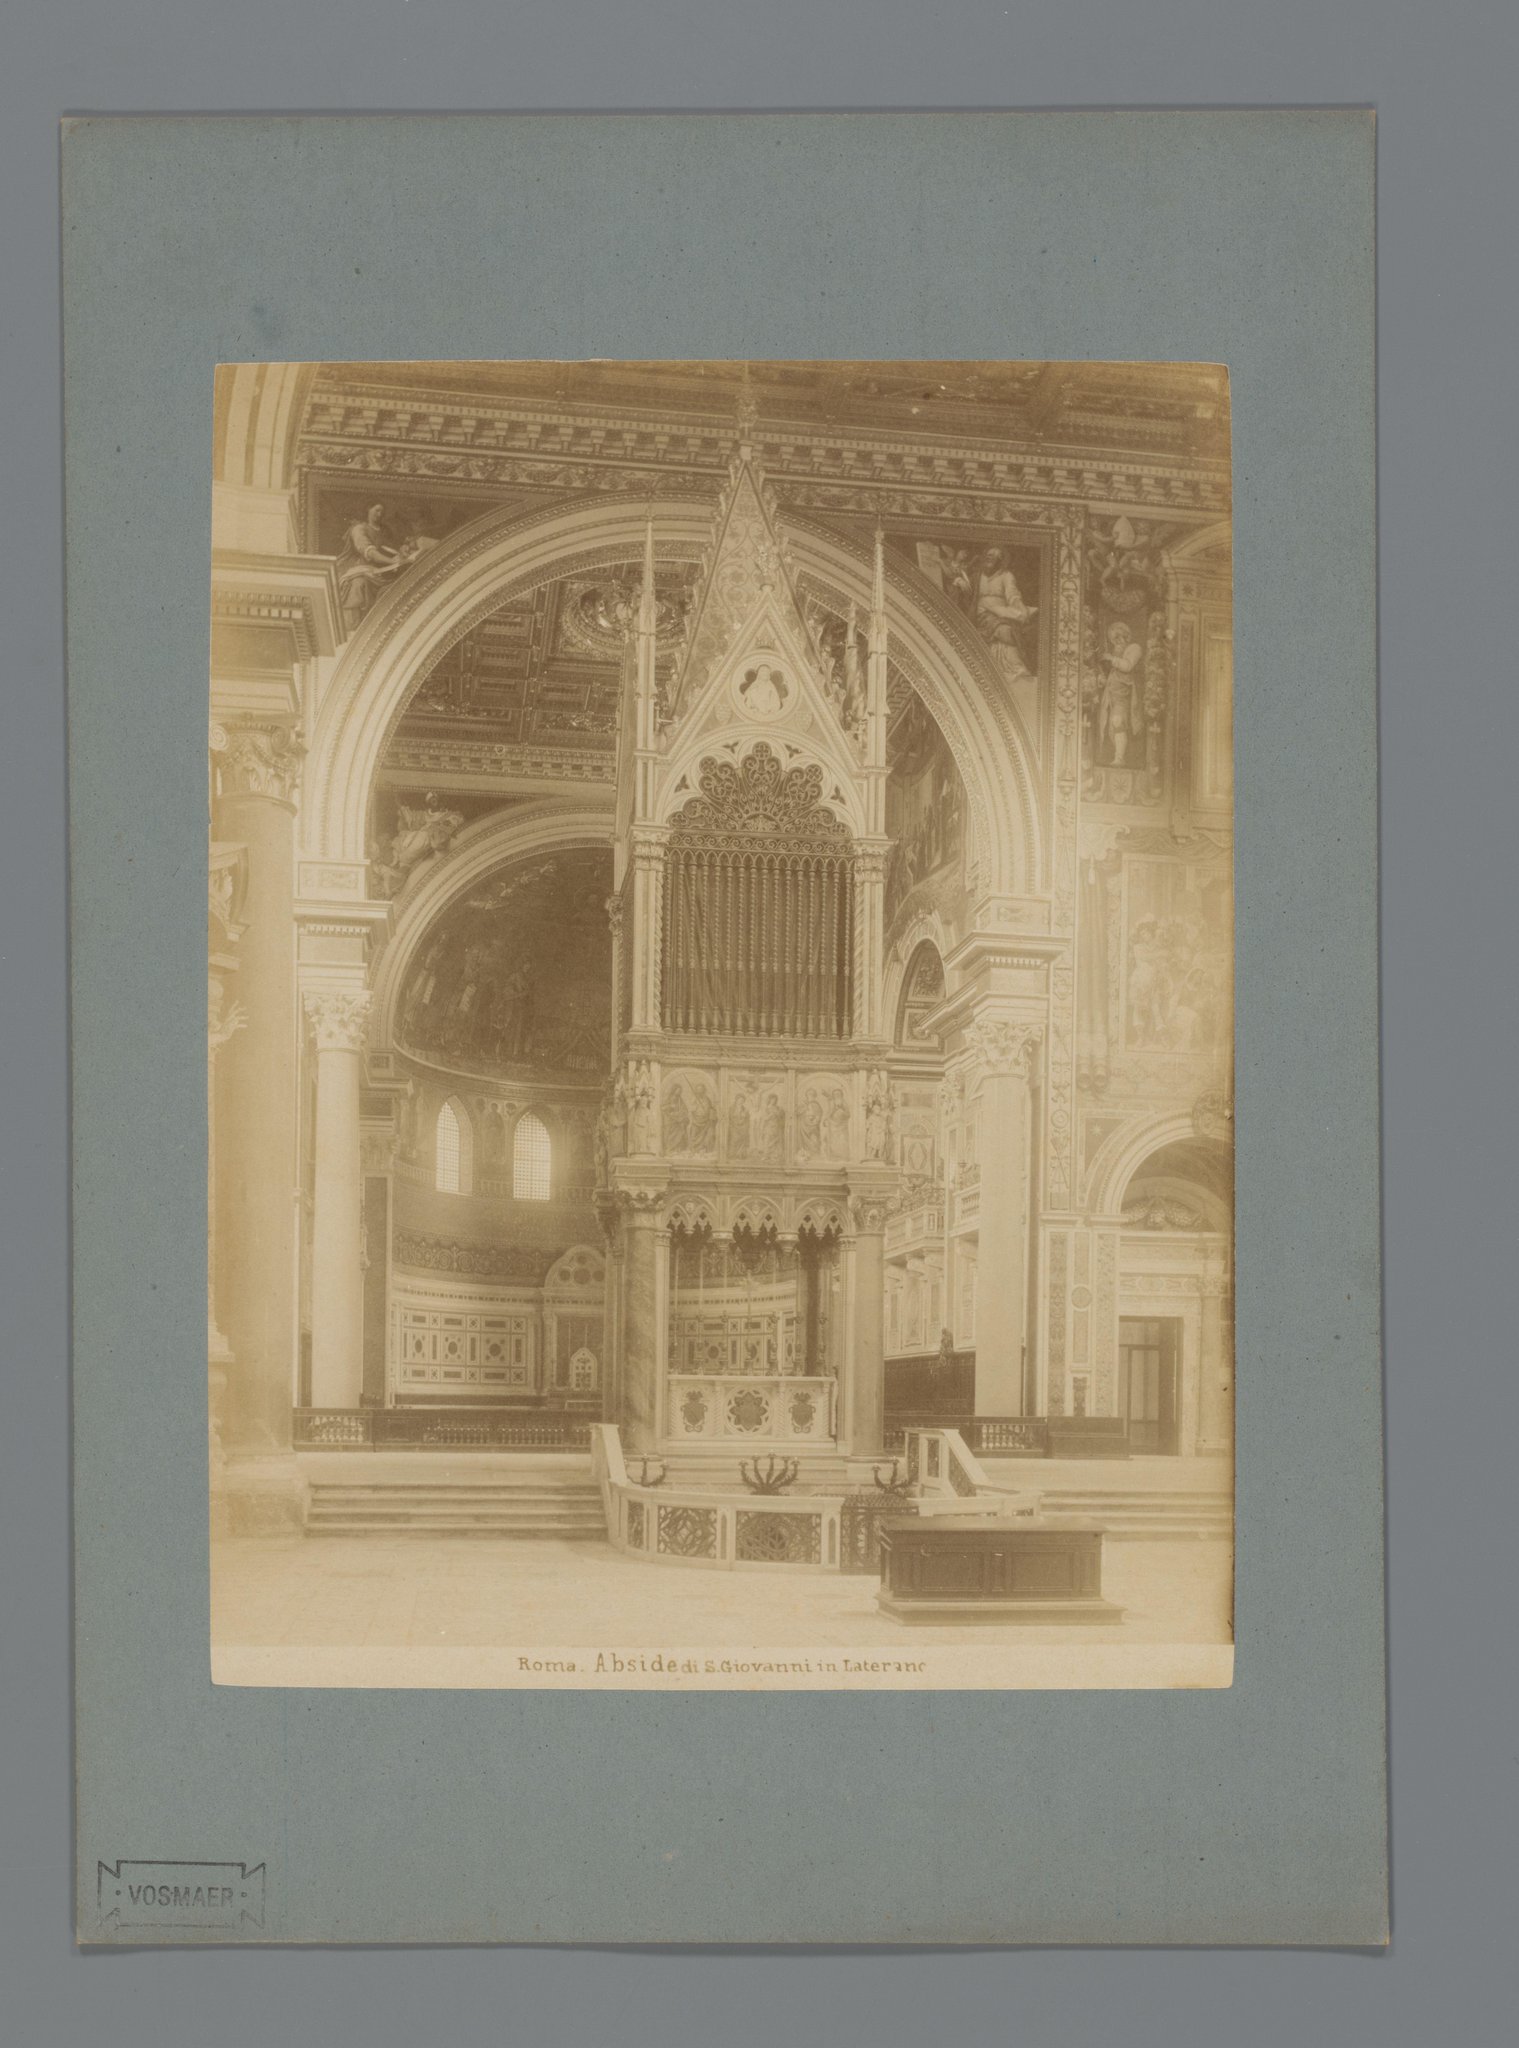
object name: photograph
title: Interieur van een apsis in de Sint-Jan van Lateranen te Rome, Italië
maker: Anonymous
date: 1851-1890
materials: cardboard, paper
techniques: albumen print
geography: rome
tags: parts of church interior: apse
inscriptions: collector's mark: ‘VOSMAER’